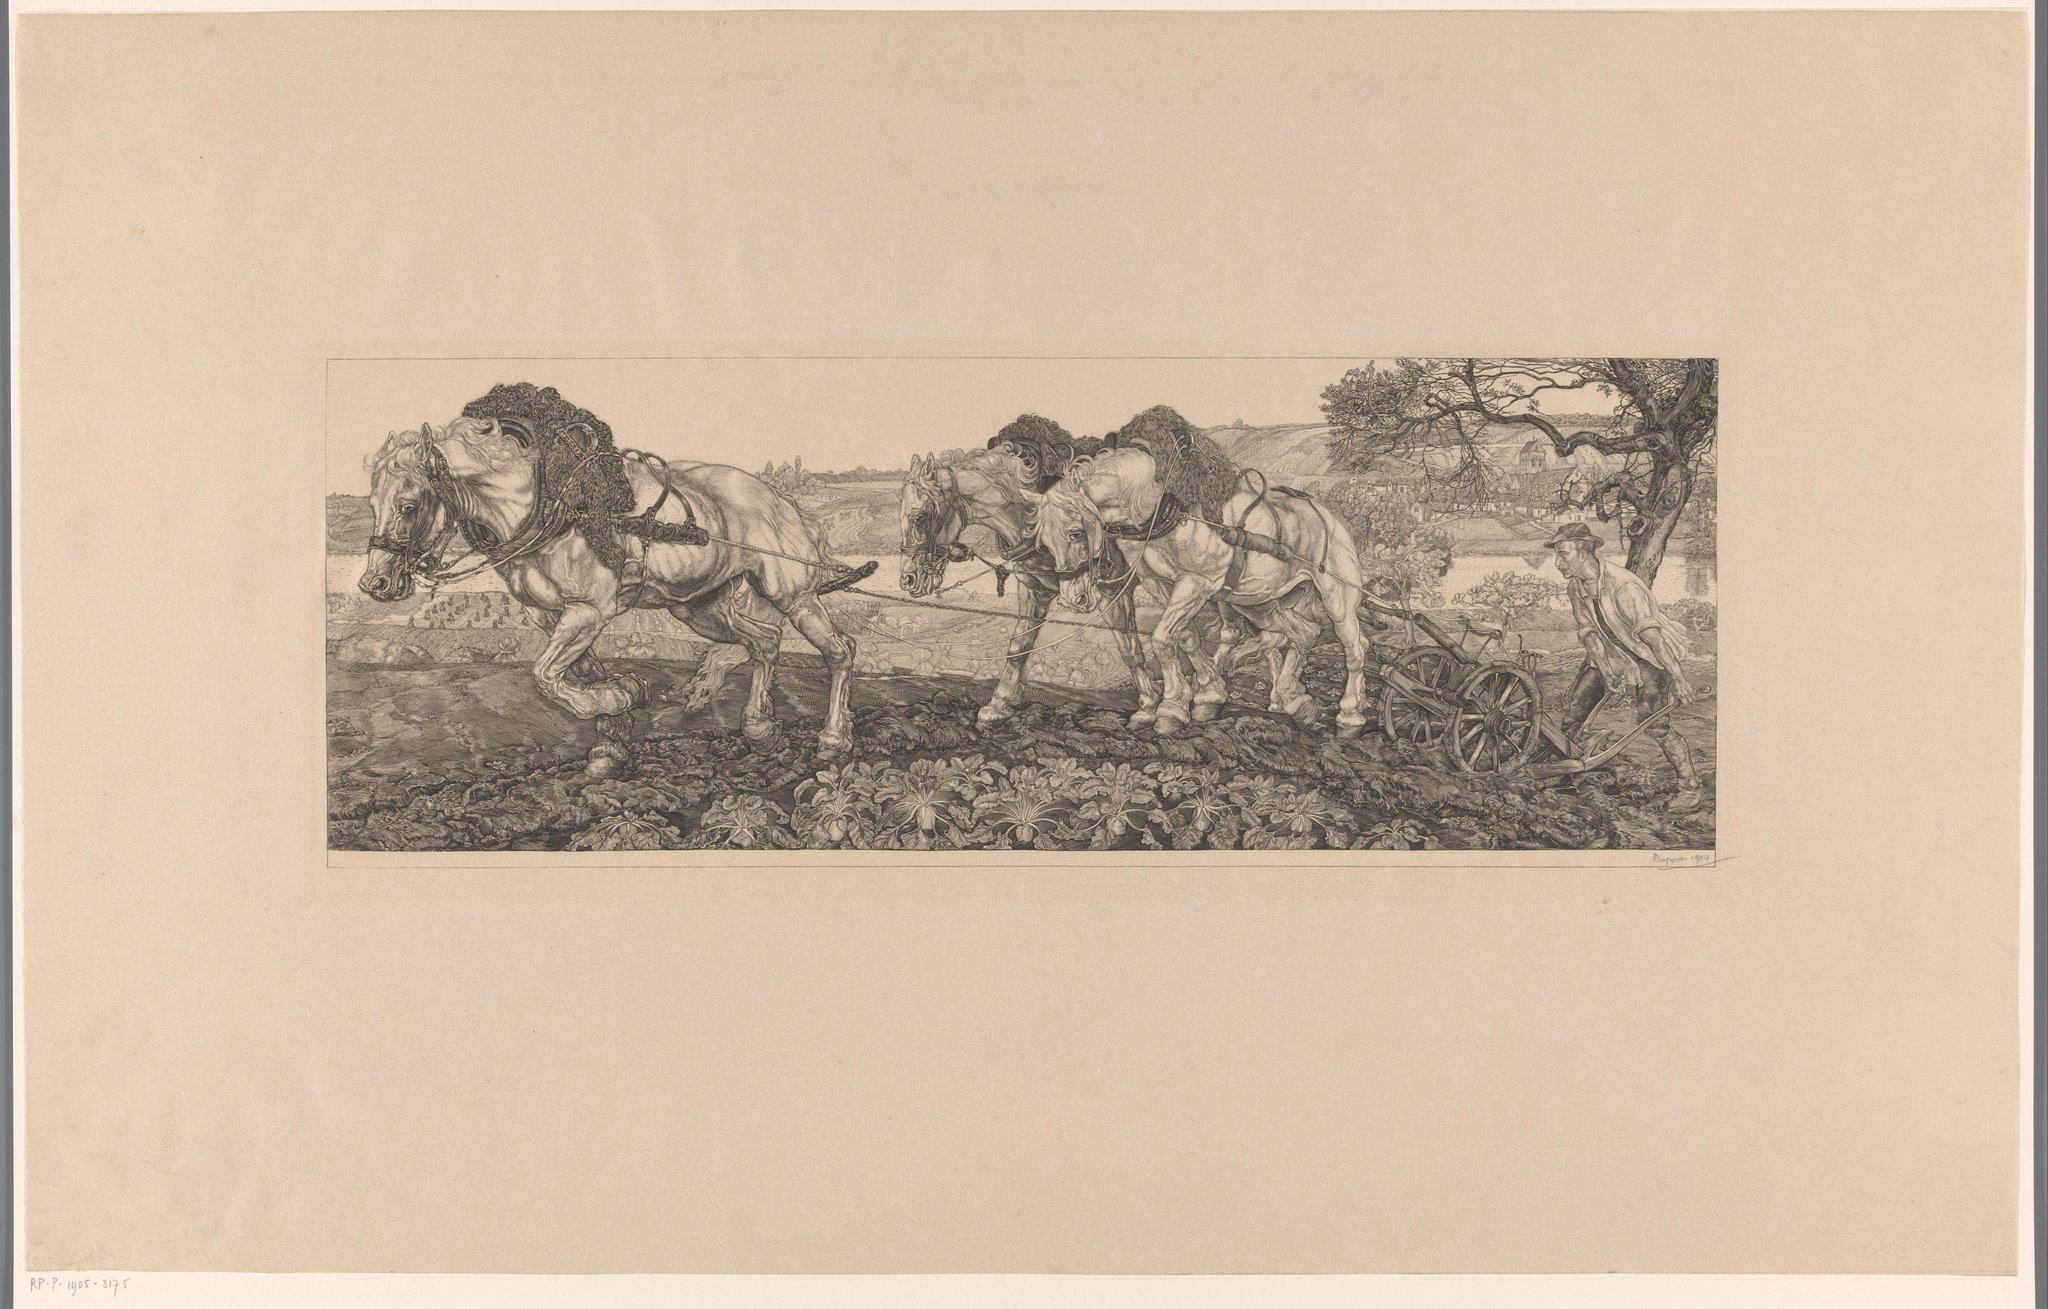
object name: print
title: Ploegende paarden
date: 1904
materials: paper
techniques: engraving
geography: amsterdam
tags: horse, agricultural implements: plough, ploughing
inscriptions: collector's mark: Lugt 2228